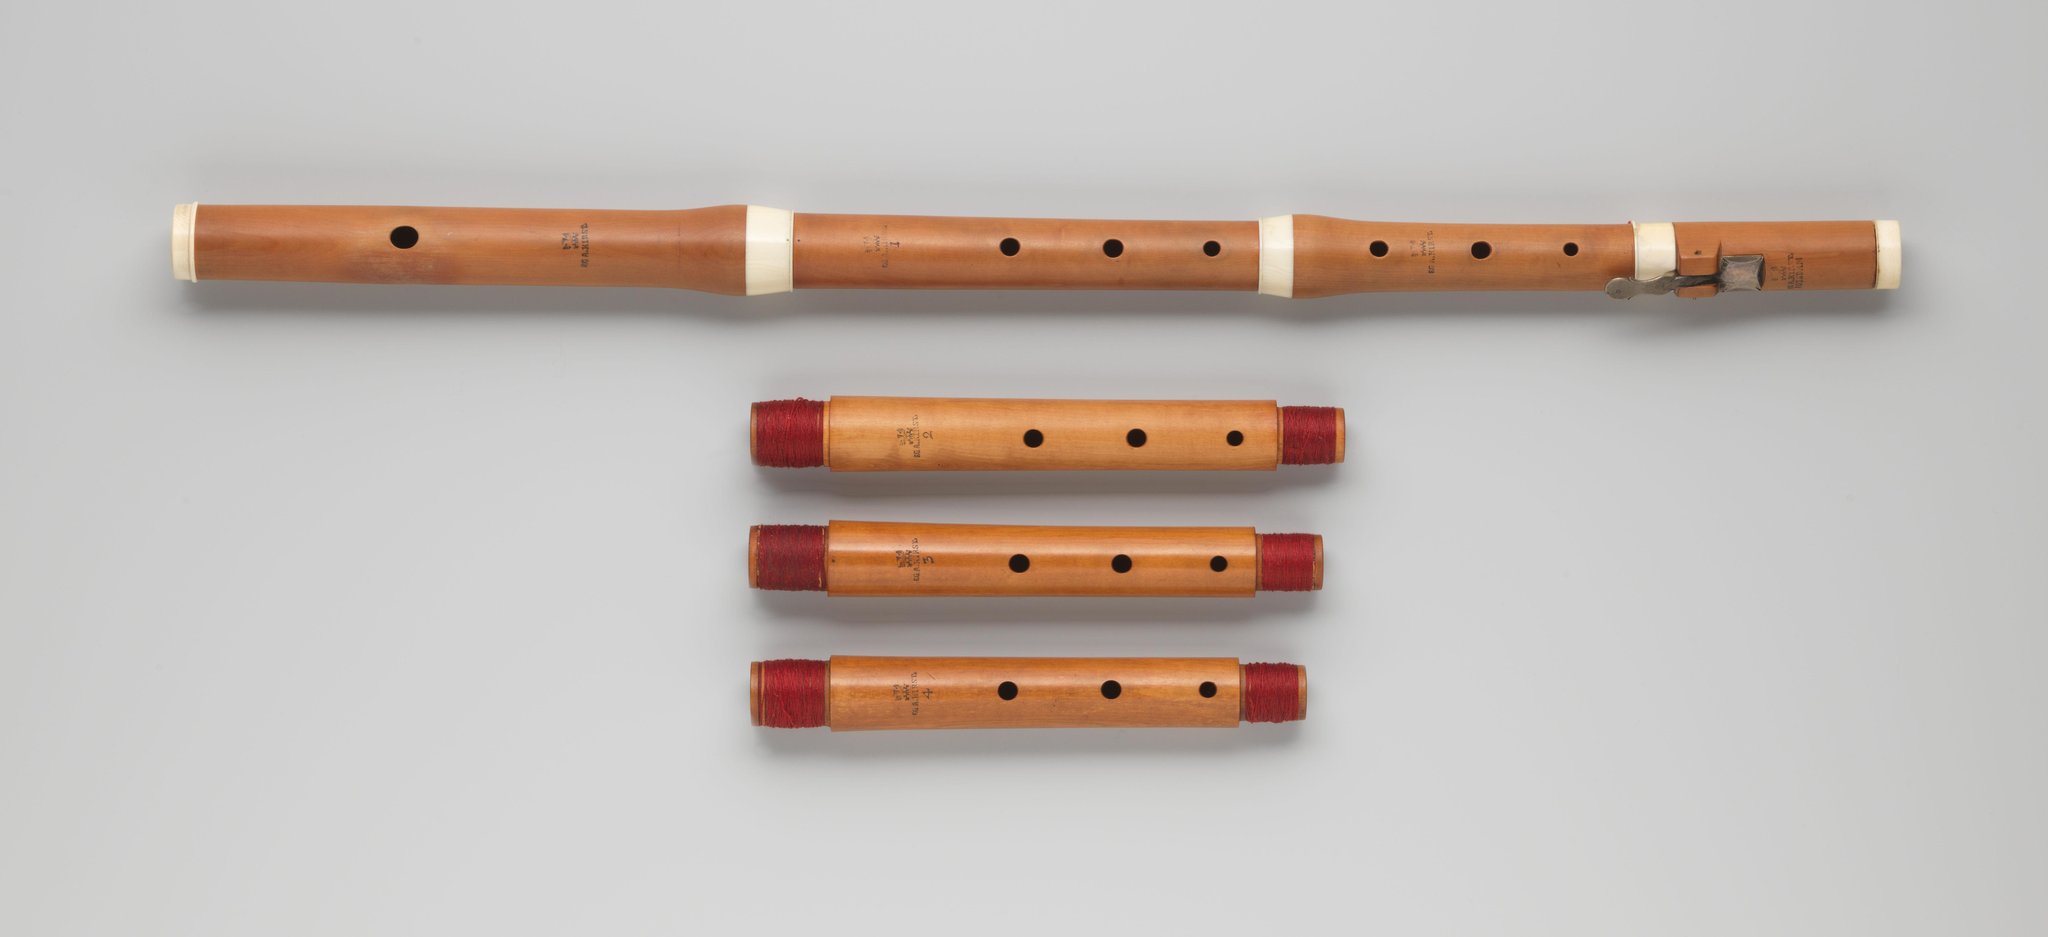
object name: wind instrument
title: Dwarsfluit met vier wisselstukken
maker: friedrich gabriel august kirst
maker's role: musical instrument maker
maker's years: 1750-1806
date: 1772-1800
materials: wood, brass, ivory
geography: potsdam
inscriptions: stamp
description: Vierdelige dwarsfluit van buxushout, met ivoren ringen en een zilveren klep; vier wisselstukken. Stemming a=ca. 447/442/447/455 Hz.